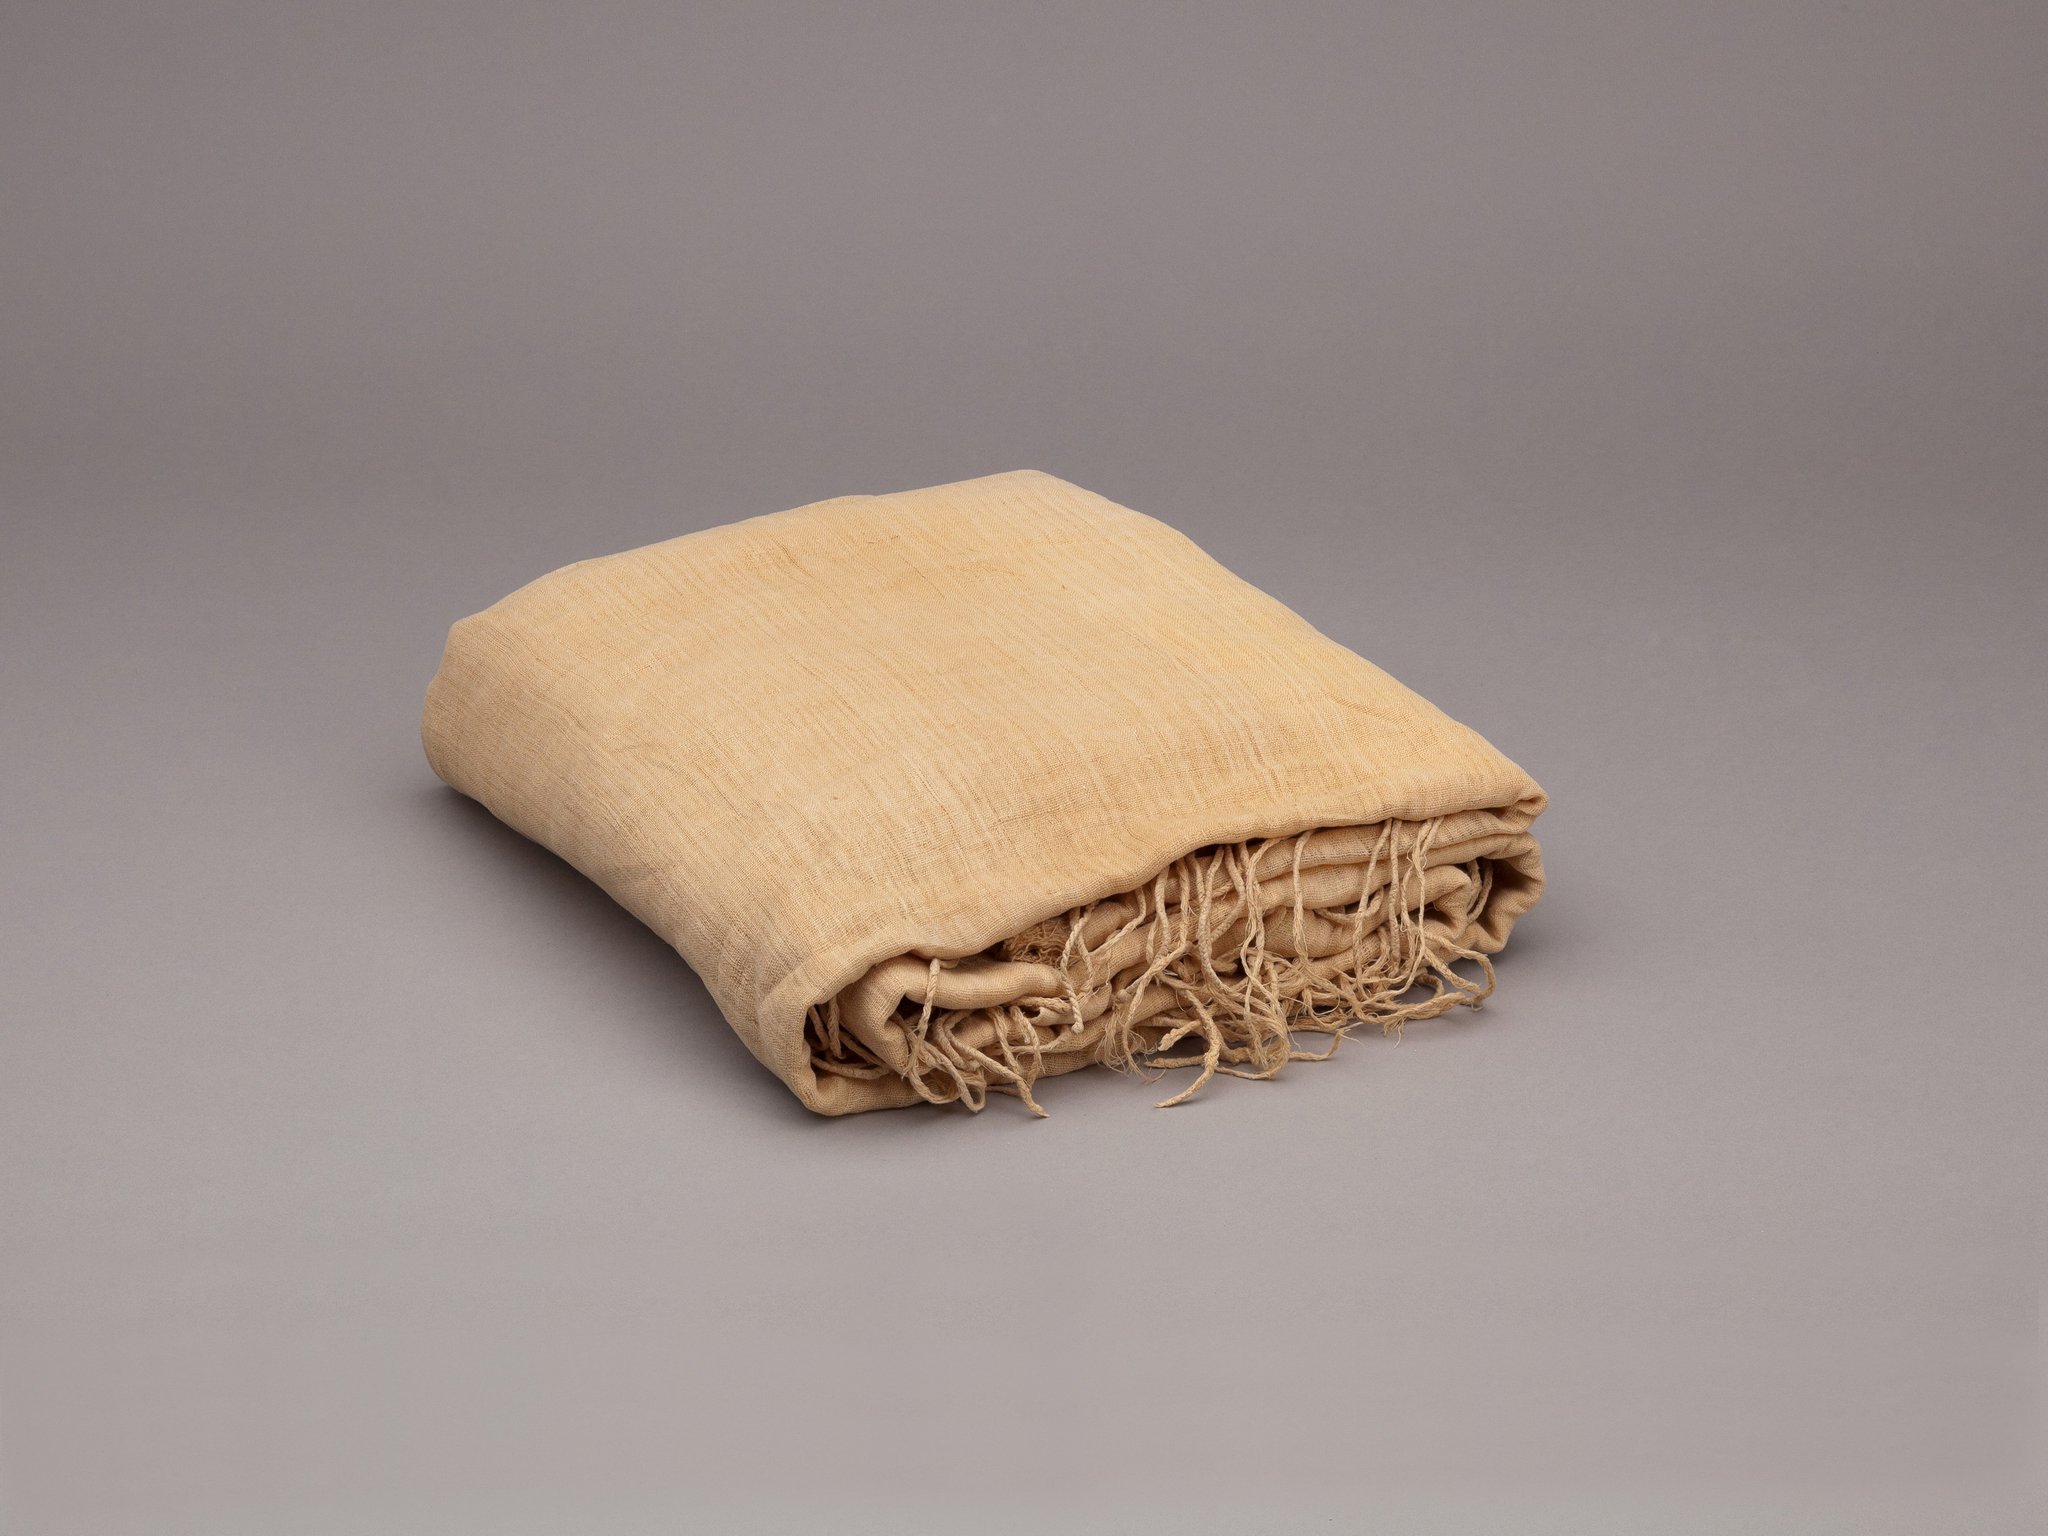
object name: linen mark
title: Sheet, linen mark, medium spin, close weave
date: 1492-1473 BCE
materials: linen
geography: egypt